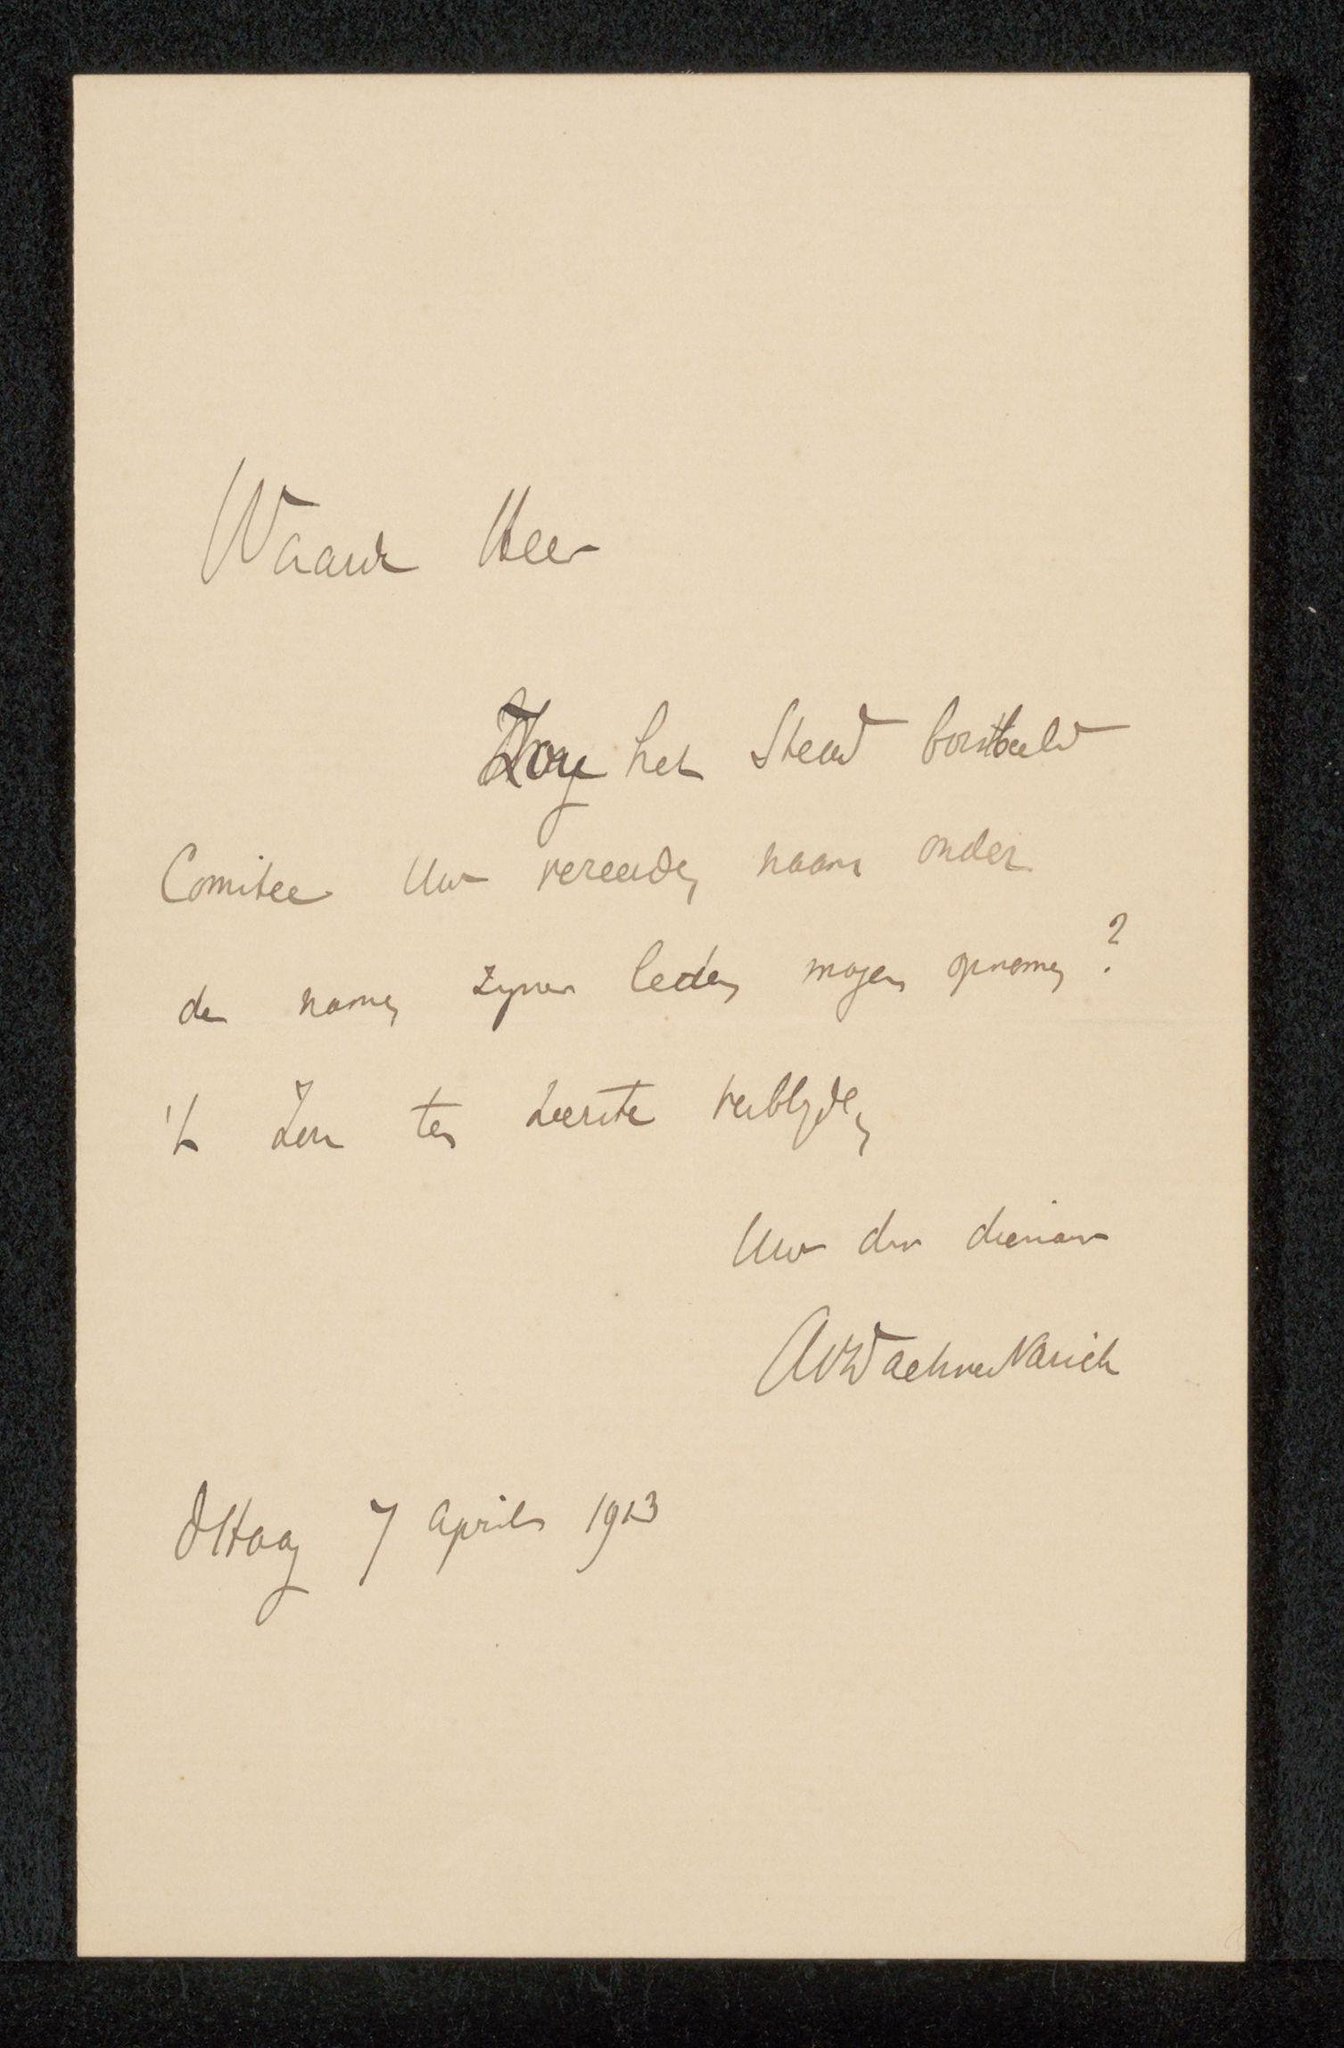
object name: letter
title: Brief aan Philip Zilcken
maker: jonkheer august von daehne van varick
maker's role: jurist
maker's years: 1846-1930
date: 1913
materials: ink, paper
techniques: pen, writing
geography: the hague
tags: the hague, painter, draughtsman, philip zilcken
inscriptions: collector's mark: ‘RPK’